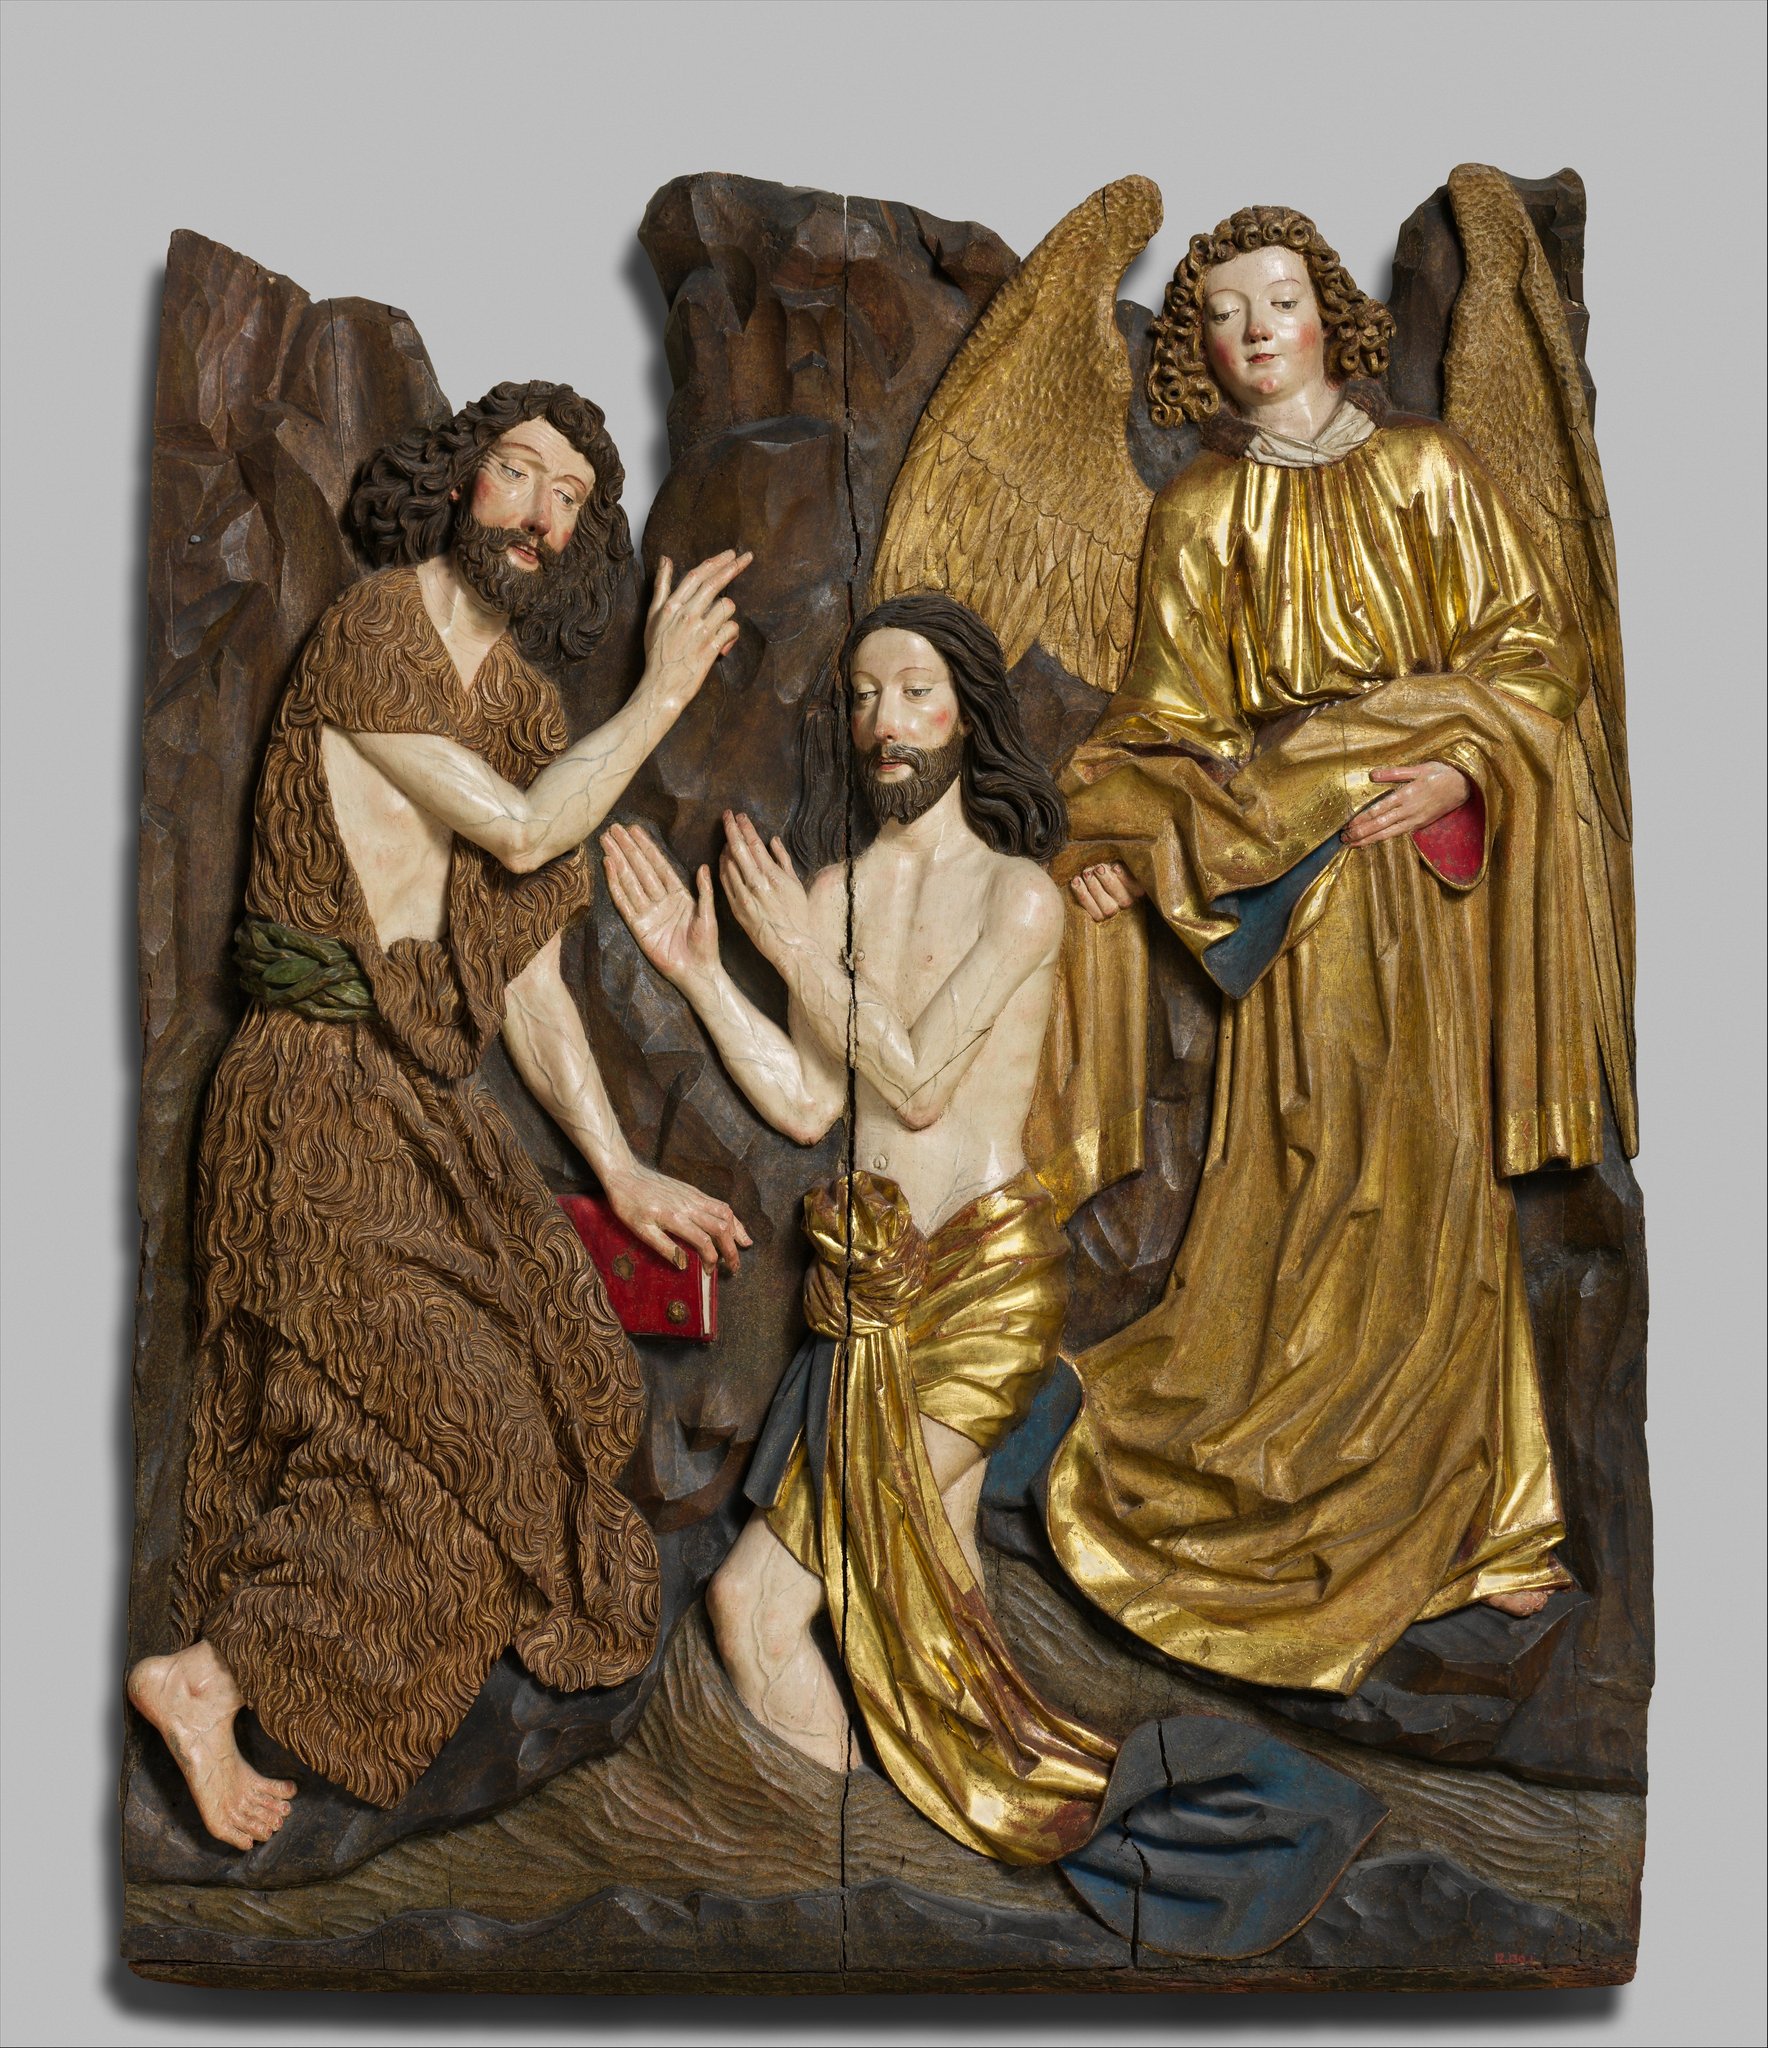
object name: relief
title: Baptism of Christ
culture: german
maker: veit stoss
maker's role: artist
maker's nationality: german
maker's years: 1440-1533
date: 1480-1490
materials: paint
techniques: gilding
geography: germany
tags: angels,christ,saint john the baptist,baptism of christ